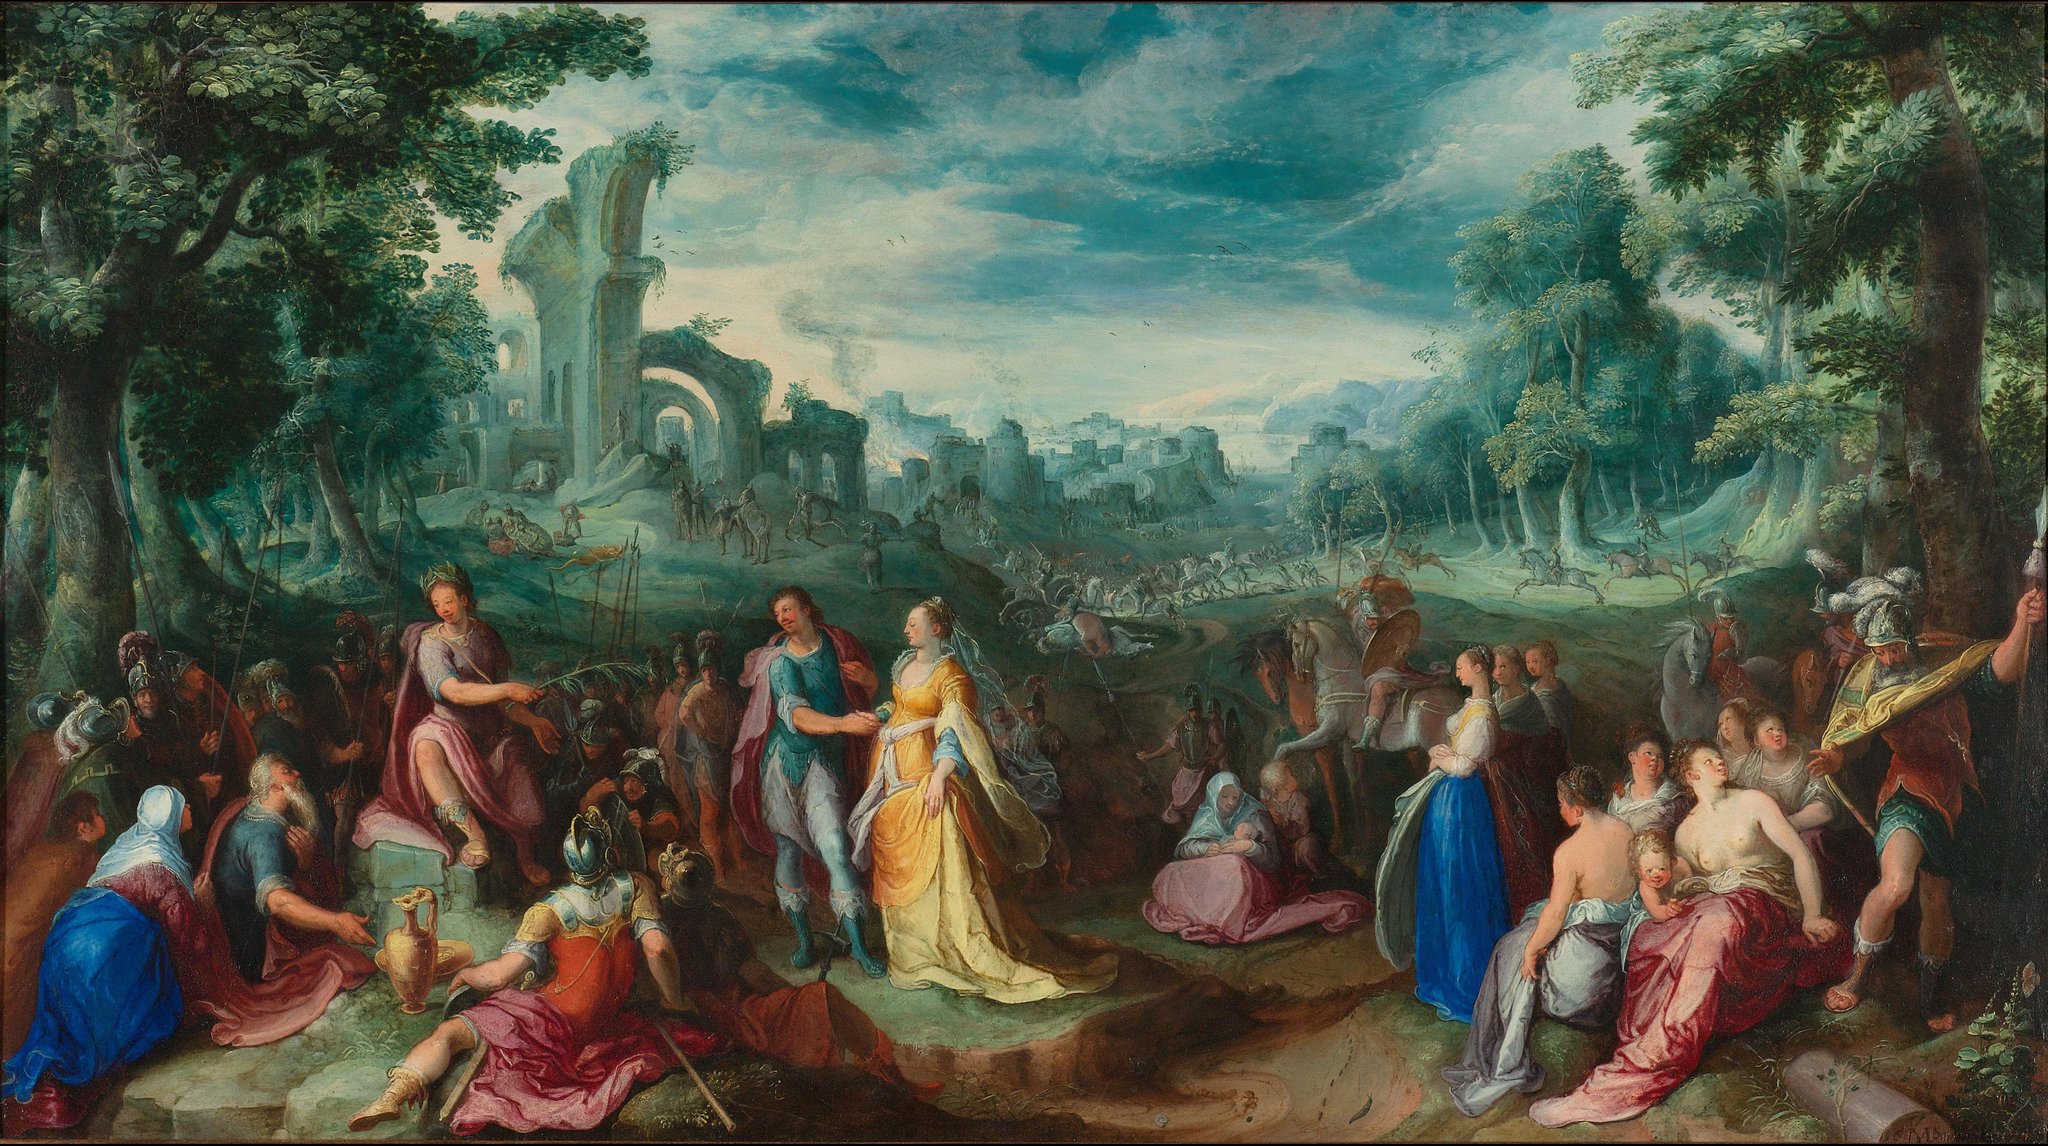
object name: painting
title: The Continence of Scipio. On the verso: Allegory on Nature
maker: karel van mander (i)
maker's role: draughtsman, painter, print maker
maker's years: 1548-1606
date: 1600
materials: copper, oil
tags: city-crown, mural crown, 'natura' (allegorical figure or scene; or as diana of ephesus, with many breasts); 'natura' (ripa), the continence of scipio: he restores a captive woman to her bridegroom allucius, who kneels before him; the ransom offered by the bride's parents is given to allucius as a wedding-gift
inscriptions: signature and date: ‘16 KM 00’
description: The Roman general Scipio has just captured New Carthage. Standing among the prisoners of war is a young woman, part of Scipio’s spoils. However he displays magnanimity. When her family and fiancé come to buy her freedom, he lets her go for free and unharmed. Van Mander created depth by painting the figures in the foreground in bright colours, while the background is less vivid.